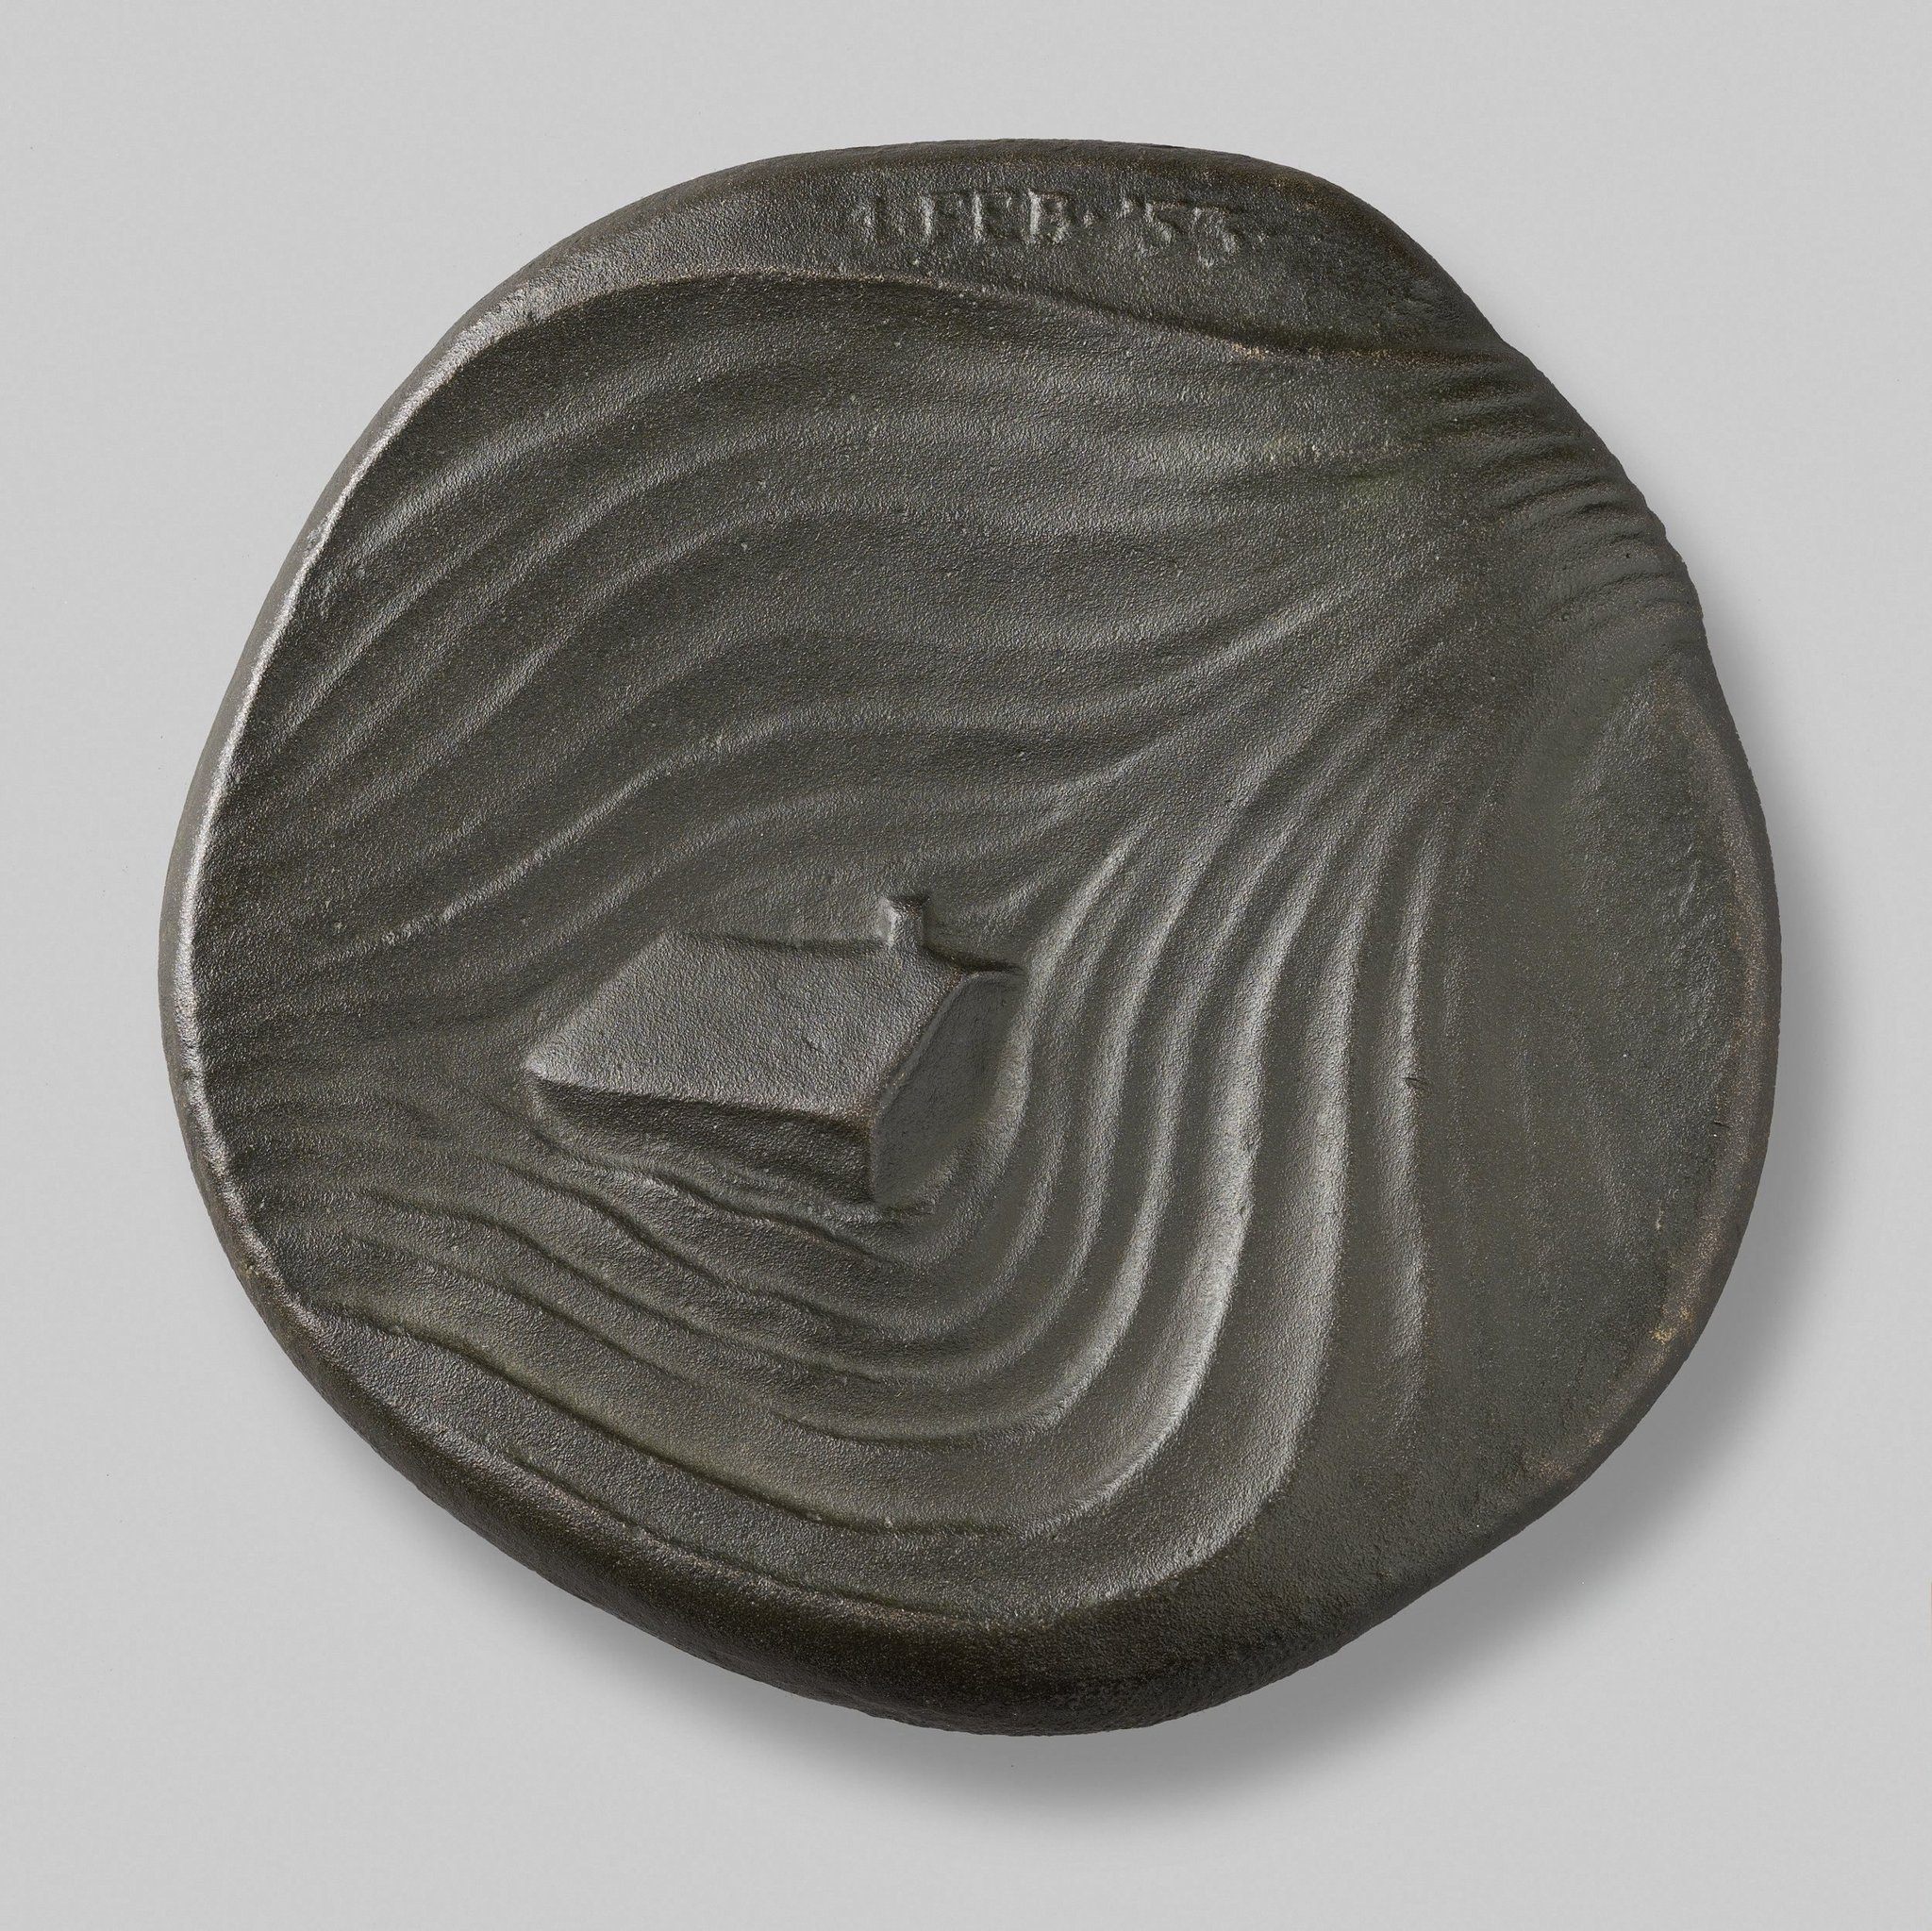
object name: medal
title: The North Sea Flood of 1953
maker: ian jacob pieters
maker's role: sculptor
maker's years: 1925-2020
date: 1953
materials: bronze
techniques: casting, patinaed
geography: netherlands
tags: netherlands, north sea flood of 1953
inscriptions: signature: ‘IJP’, date: ‘1 FEB. '53’, date: ‘6 NOV. '53’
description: Flood Disaster Medals. Much of the Netherlands lies below sea level. The threat of flooding is thus ever-present. Dikes, dams and polders were created to control the water. Still, these safety measures sometimes failed. Each century witnessed disastrous floods, with levees breaching and the countryside being inundated. The North Sea Flood of 1953 led to the construction of the Delta Works. Thanks to this major intervention the country has since remained dry.